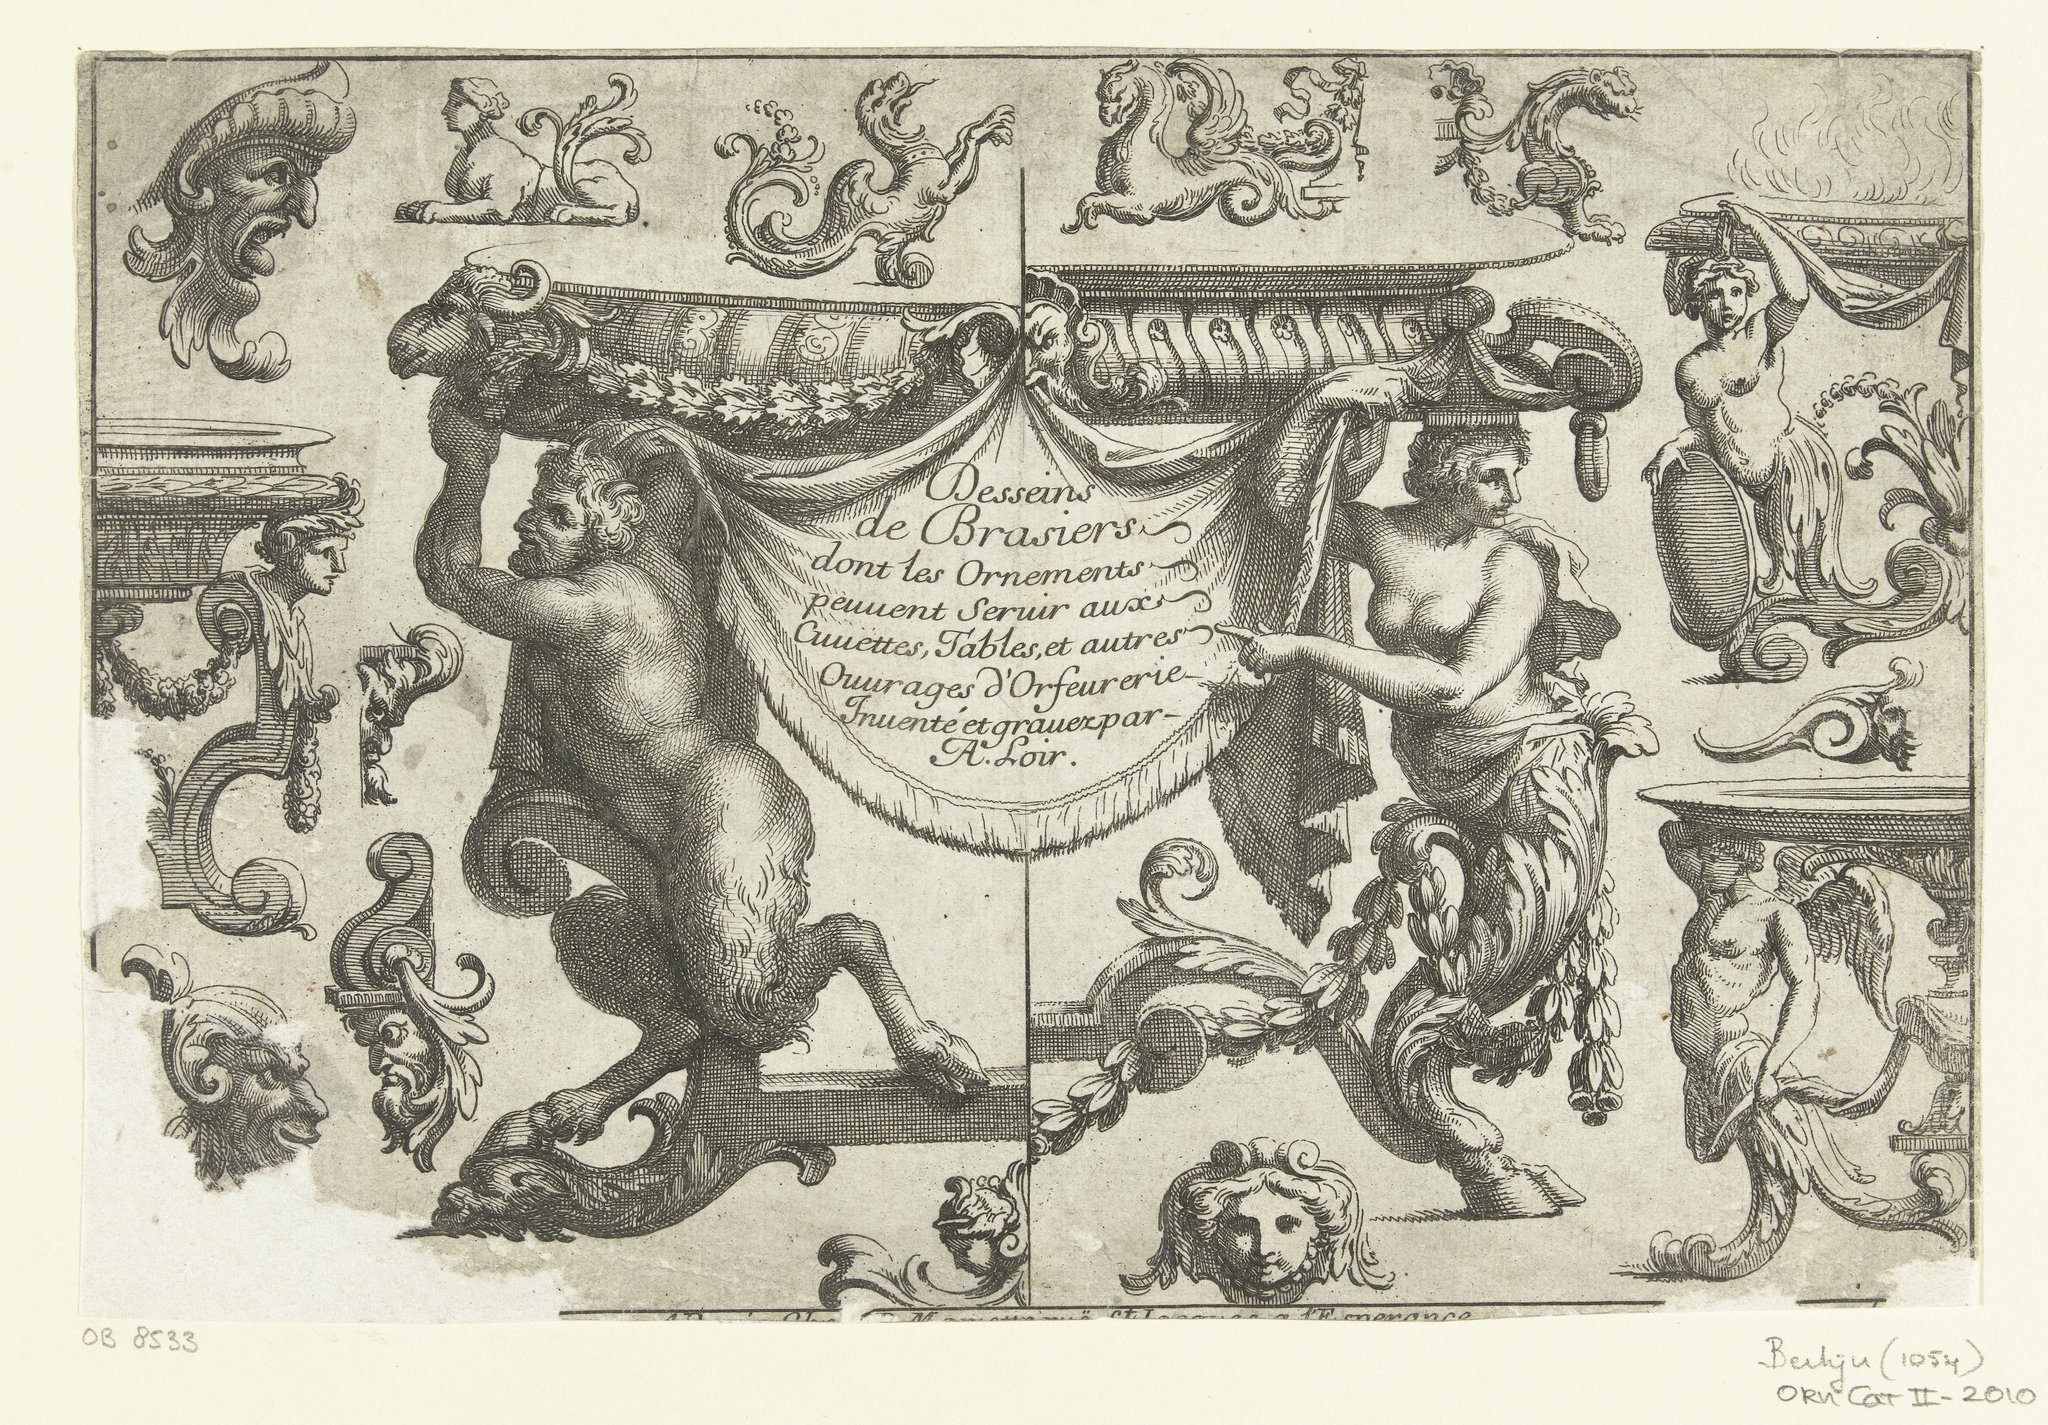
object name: ornament print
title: Desseins de brasiers dont les ornements peuvent servir aux cuvettes, tables et autres ouvrages d'orfevrerie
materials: paper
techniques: engraving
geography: paris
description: In het midden een stoof met een variant voor de rechterhelft, links gedragen door een sater en rechts door een vrouw die ontspruit uit een bladrank. Beide houden een doek vast waarop de titel staat. Daaromheen bevinden zich drie halve stoven en kleinere ornamenten. Titelblad uit serie van 6 bladen, eerste editie.